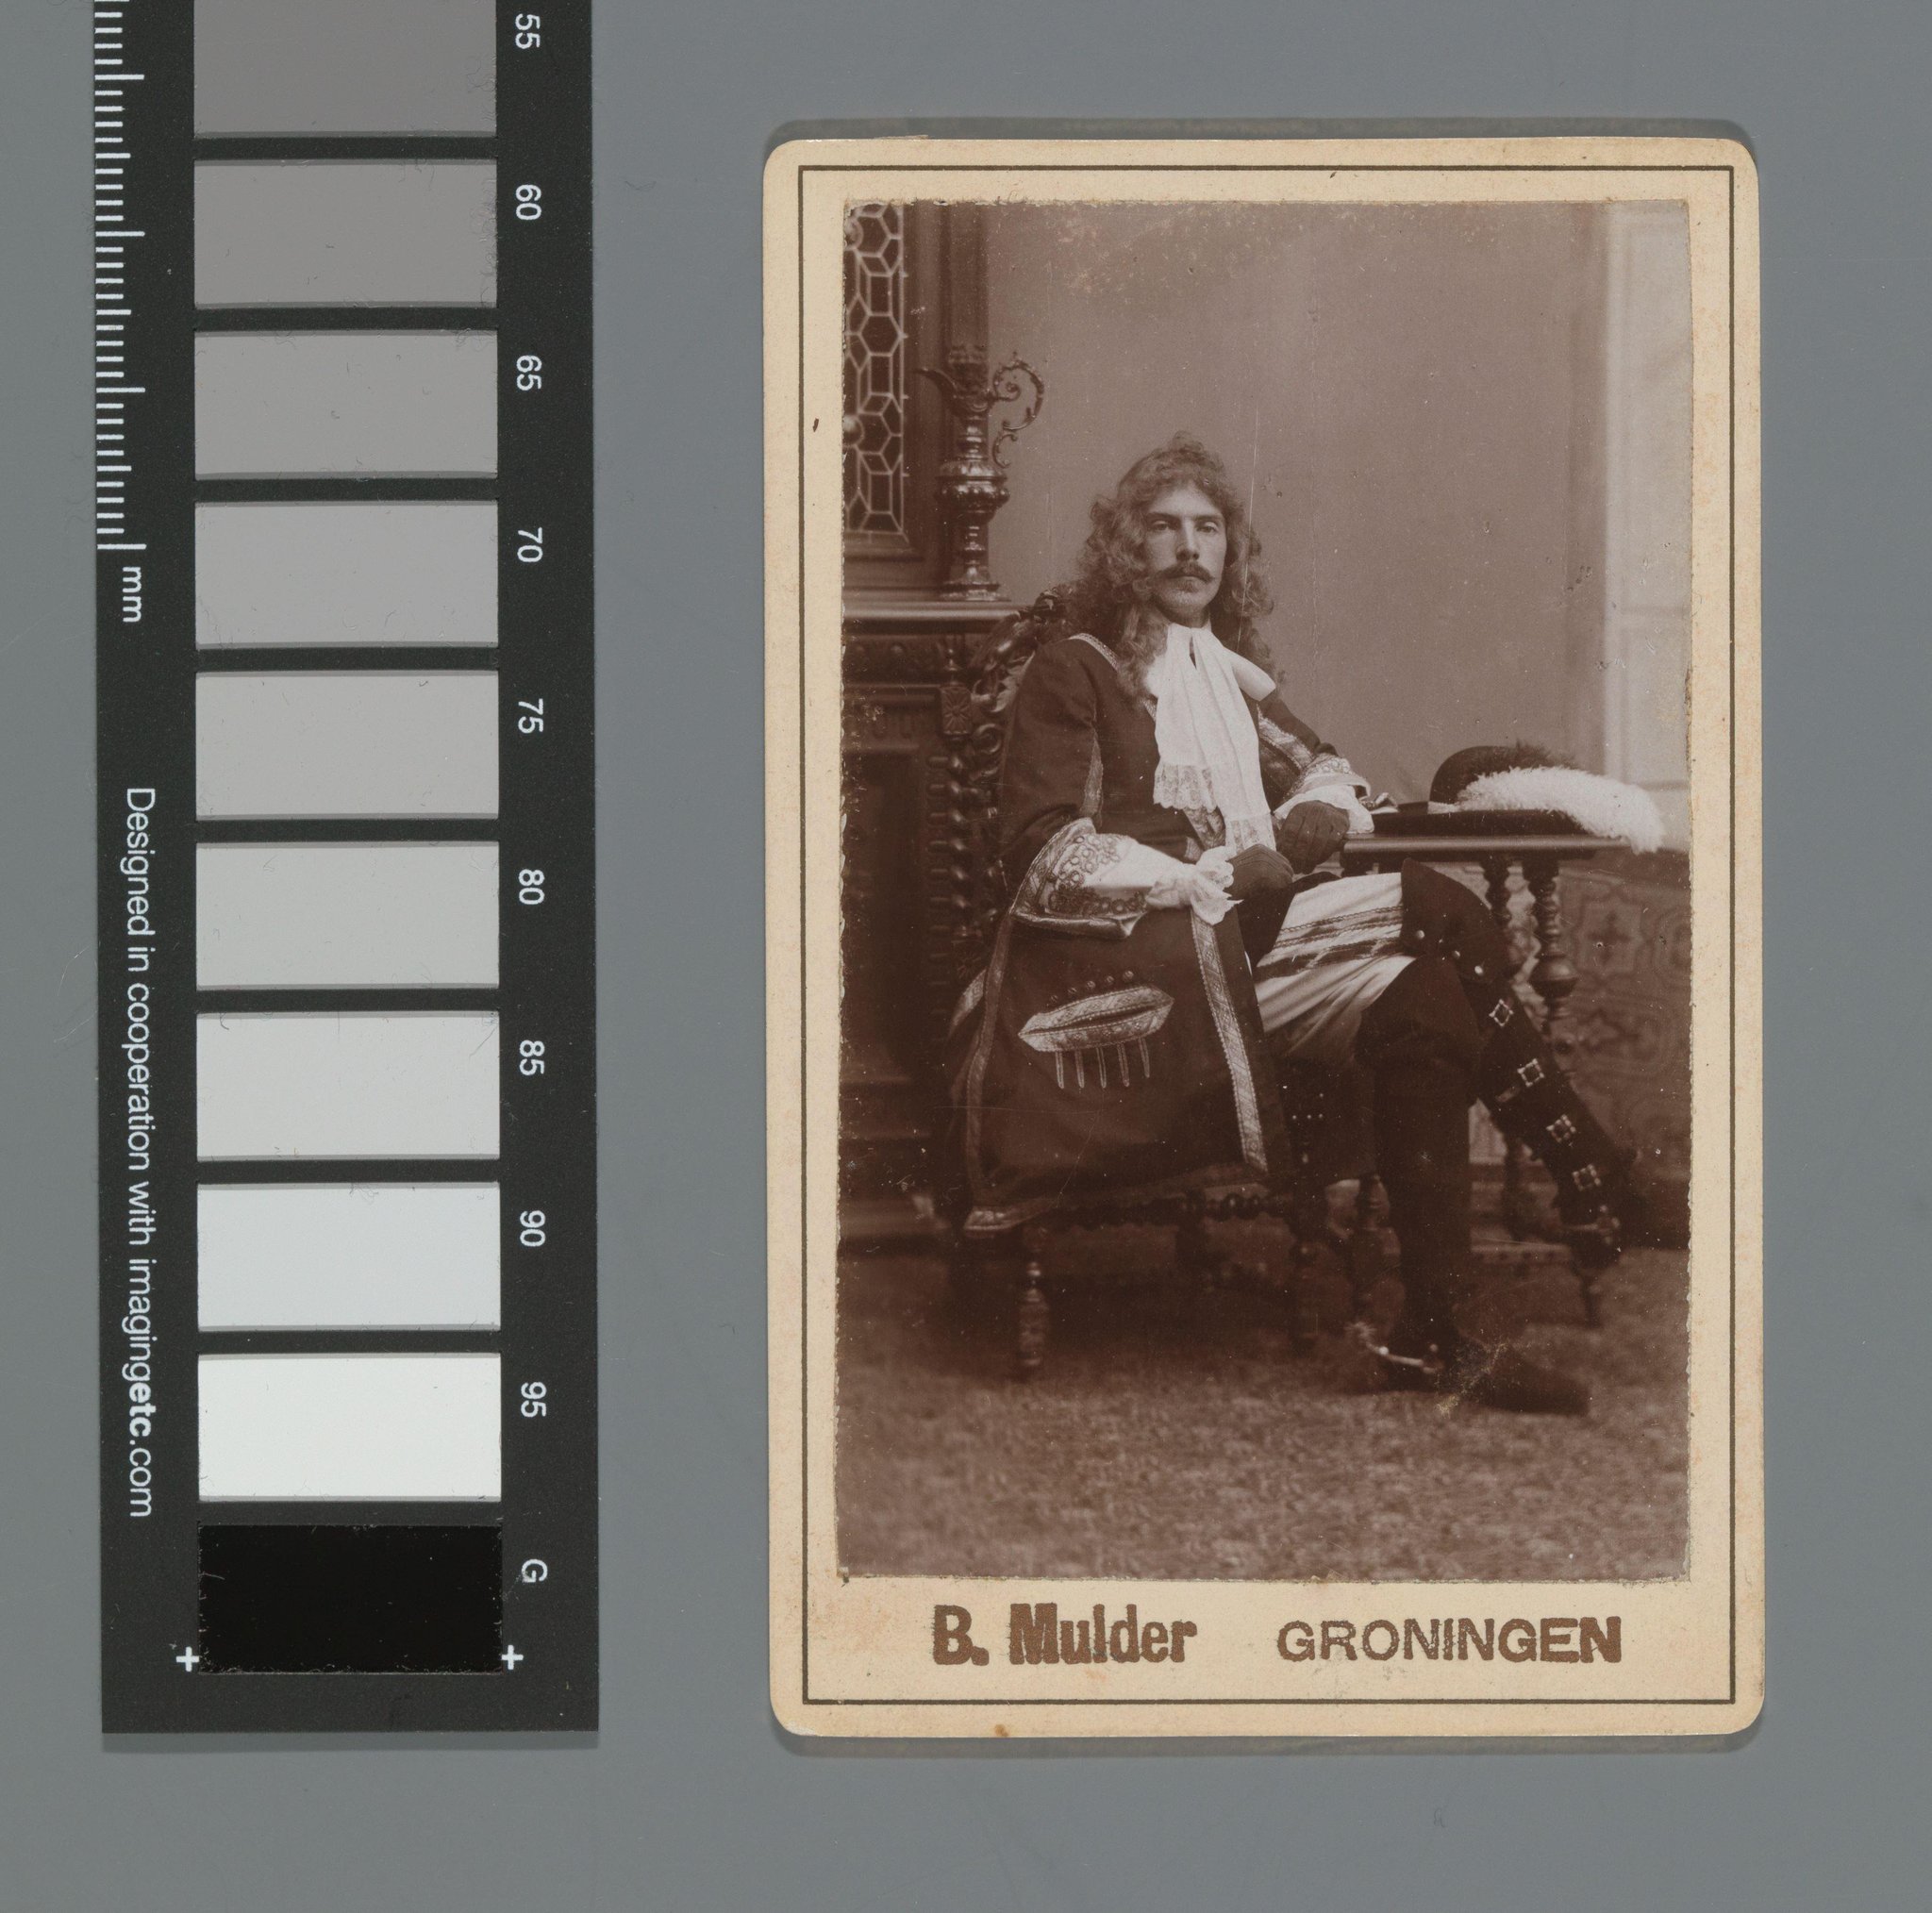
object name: carte de visite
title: Portret van een onbekende Groningse student in maskeradekostuum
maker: berend mulder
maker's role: fotograaf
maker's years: 1854-1926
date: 1880-1905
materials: paper, cardboard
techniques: collodion silver print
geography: groningen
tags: students' pageant, costumes used in pageants, anonymous historical person portrayed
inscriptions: inscription: ‘B. Mulder Groningen’